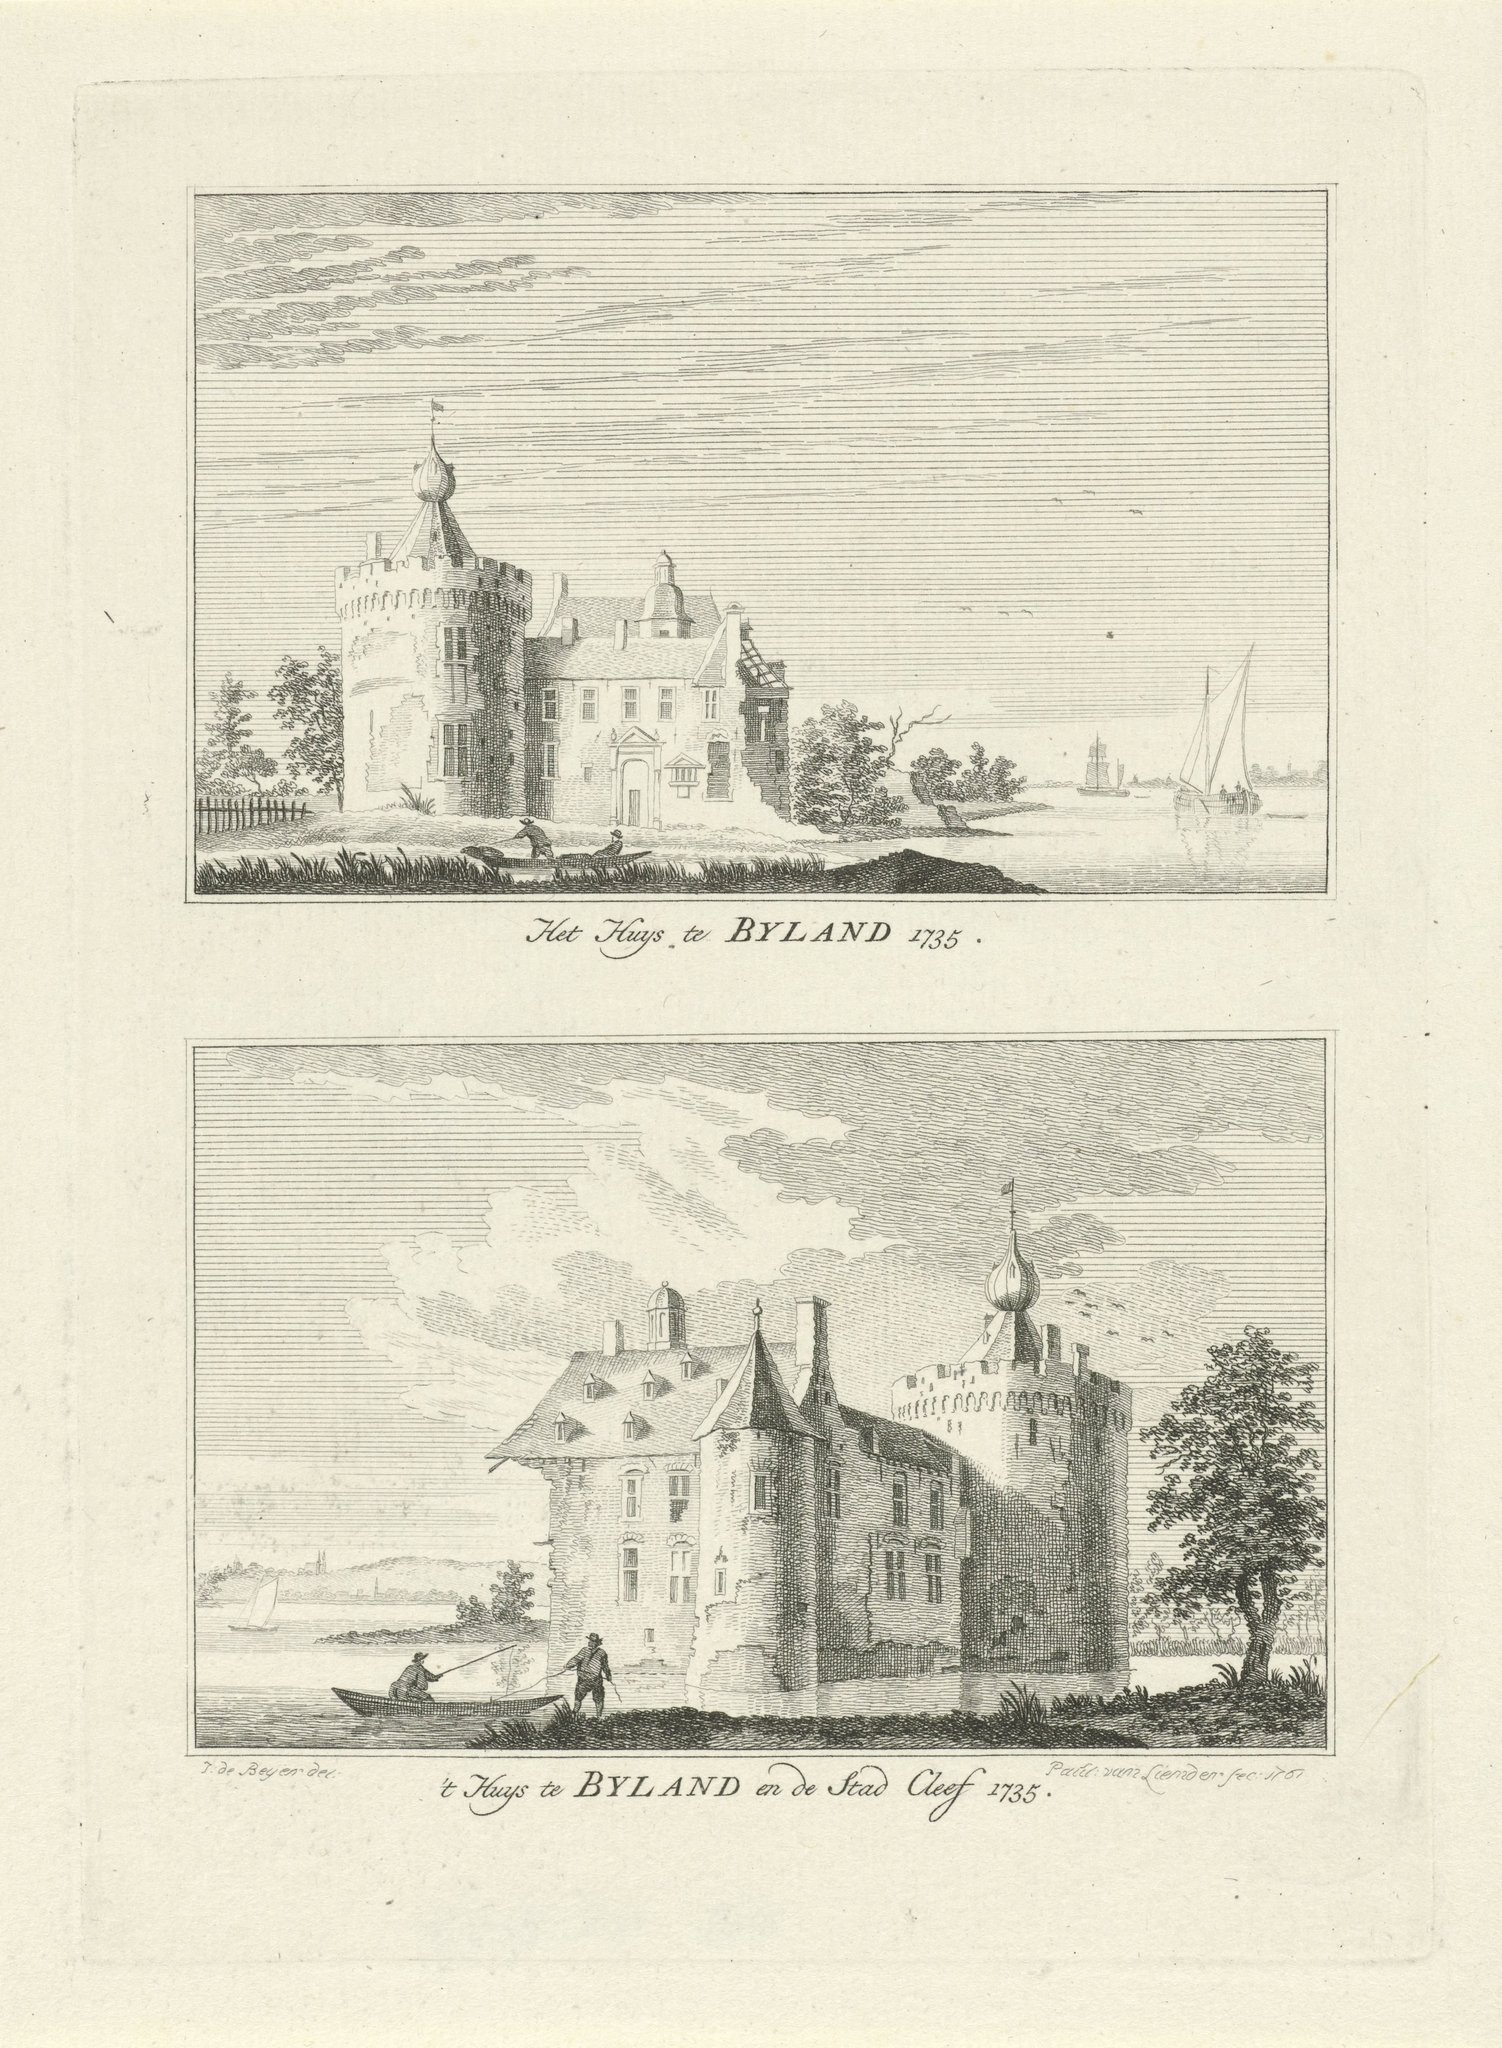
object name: print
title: Het Huys te Byland 1735 / 't Huys te Byland en de stad Cleef 1735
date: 1761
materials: paper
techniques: etching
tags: castle, prospect of city, town panorama, silhouette of city, cleves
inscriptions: collector's mark: Lugt 240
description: Twee voorstellingen van één plaat. Twee gezichten op Kasteel Bylandt, in de verte ligt de Duitse stad Kleef. De prent maakt deel uit van een 100-delige serie met gezichten op dorpen en steden te Kleef.